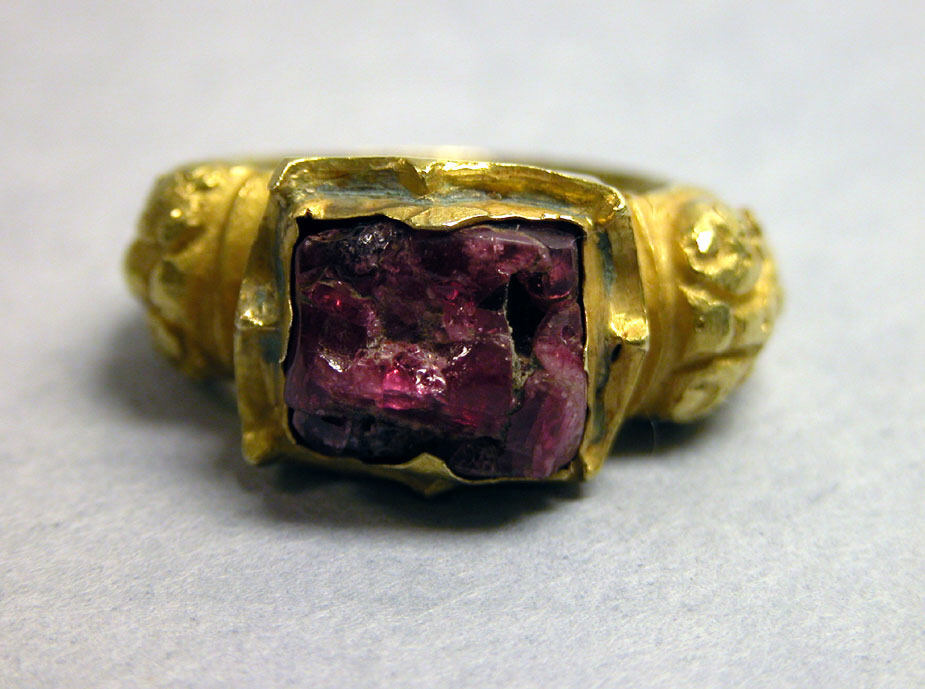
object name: ring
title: Stirrup-shaped Ring with Purple Stone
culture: indonesian, javanese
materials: gold, stone